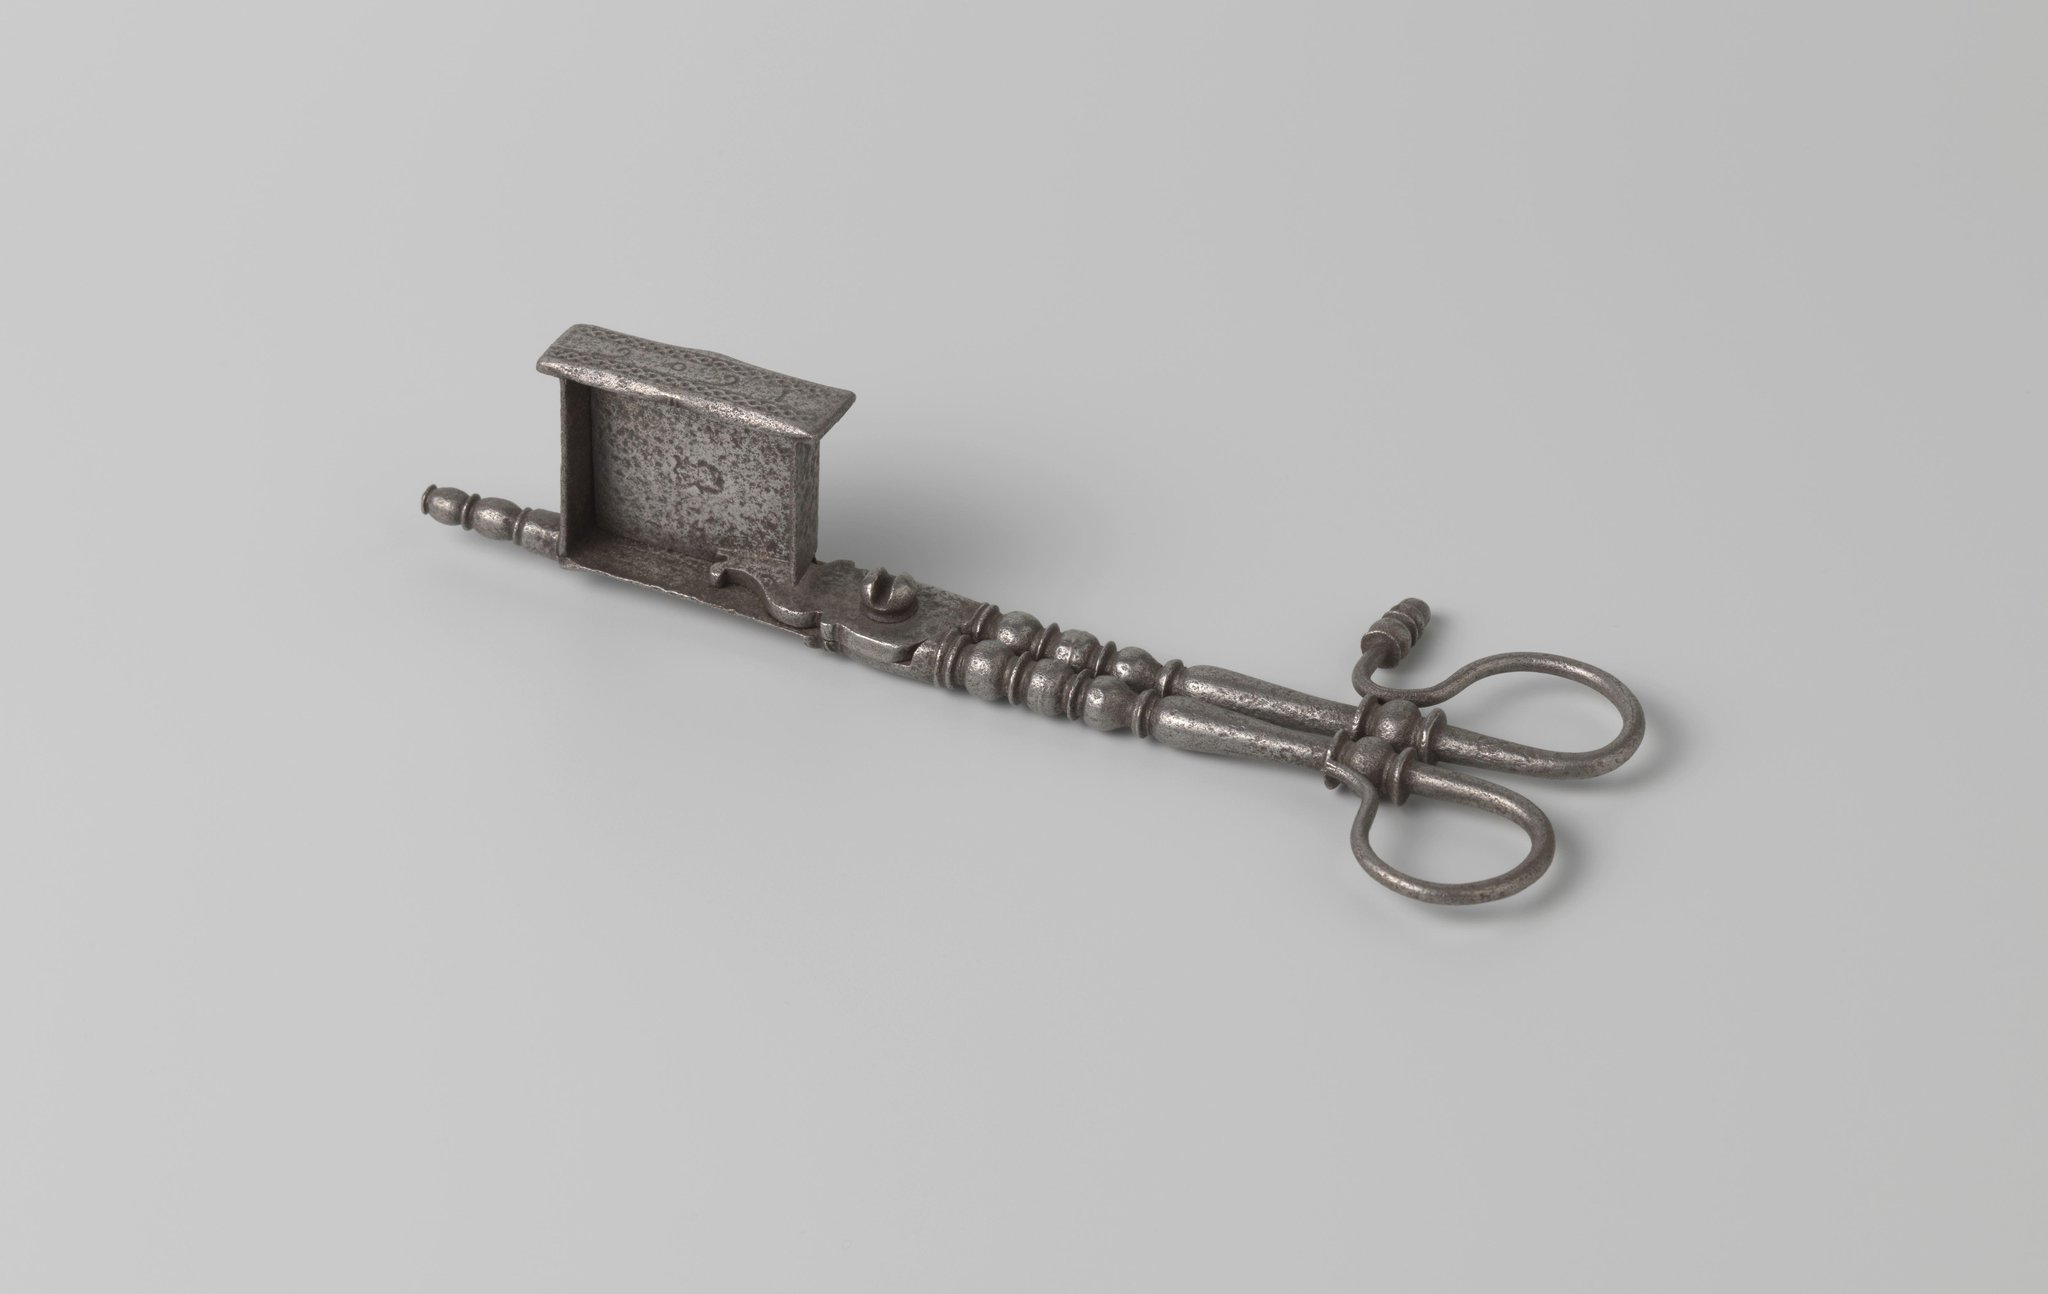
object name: snuiter, snuiterschaar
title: Snuiter van ijzer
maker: Anonymous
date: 1606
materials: iron